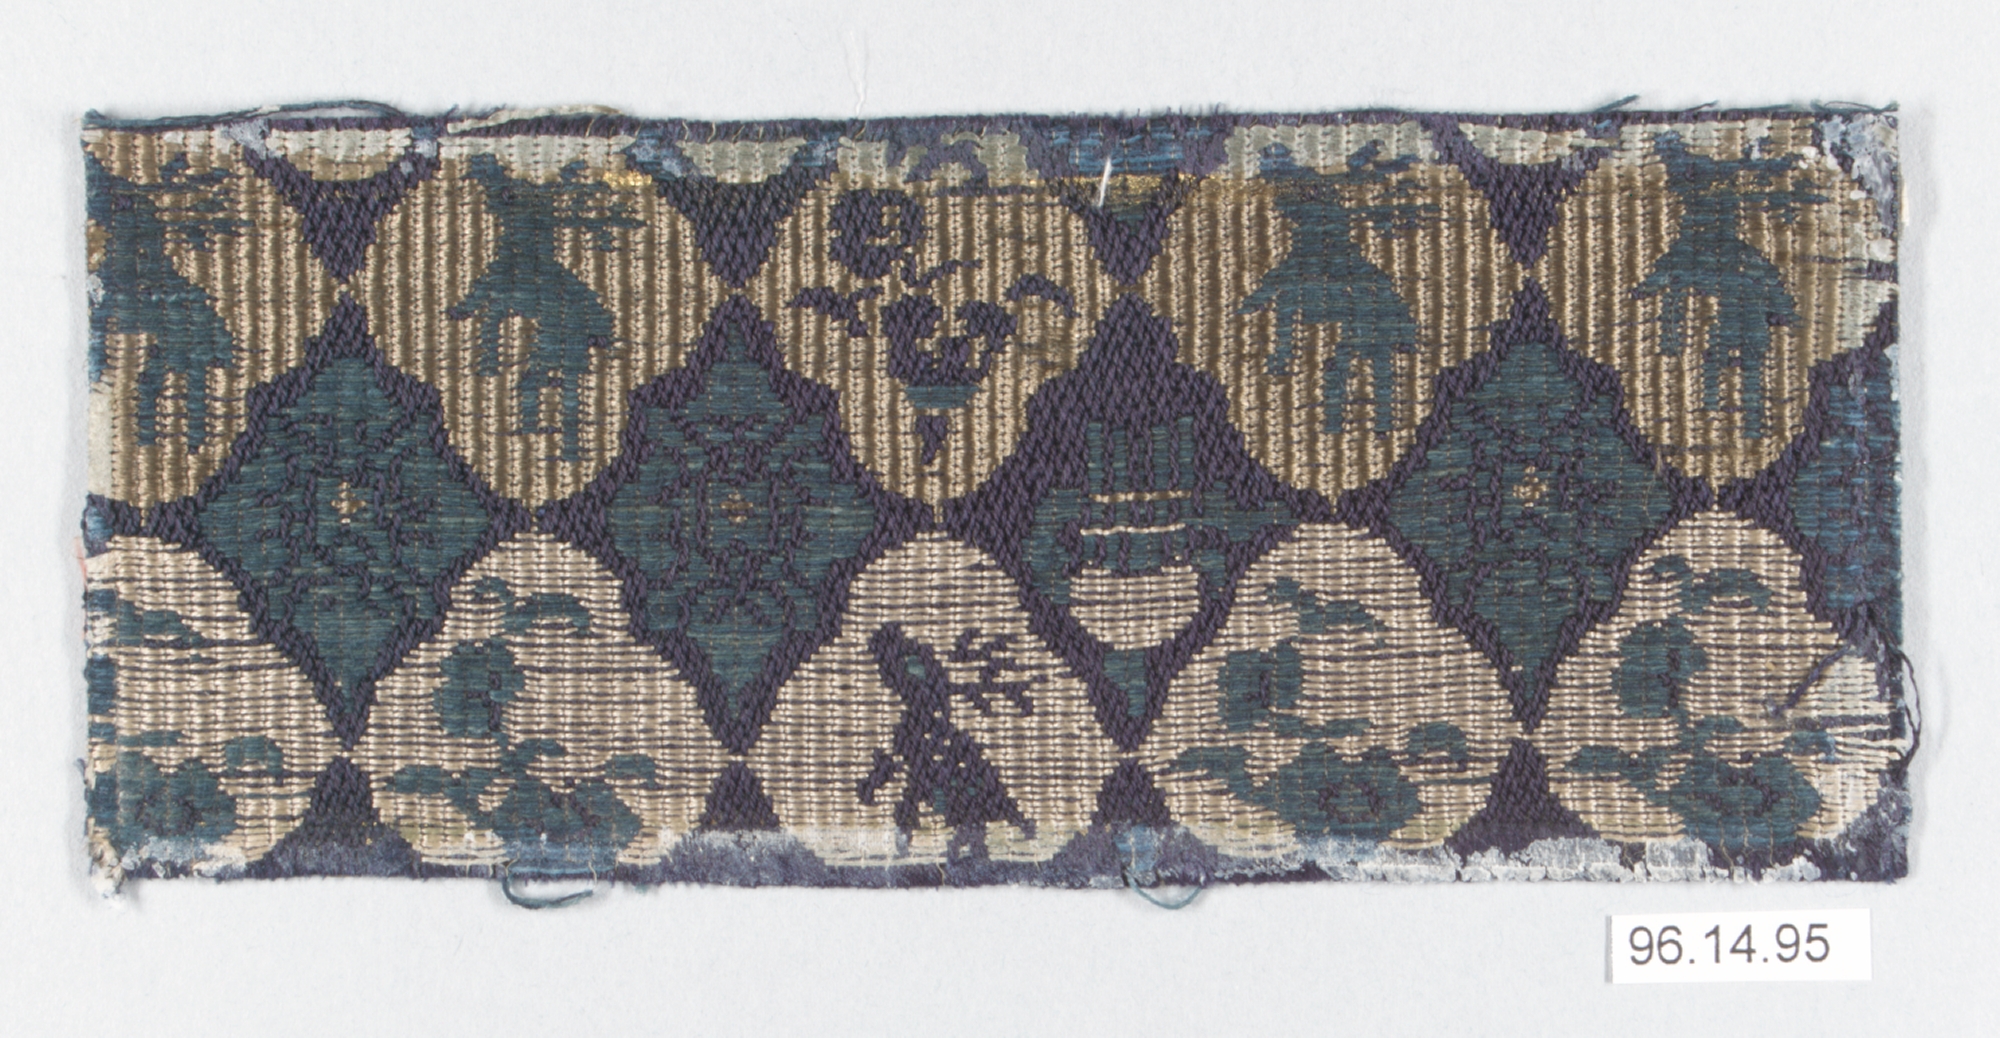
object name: piece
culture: japanese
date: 1701-1900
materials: silk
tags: deer